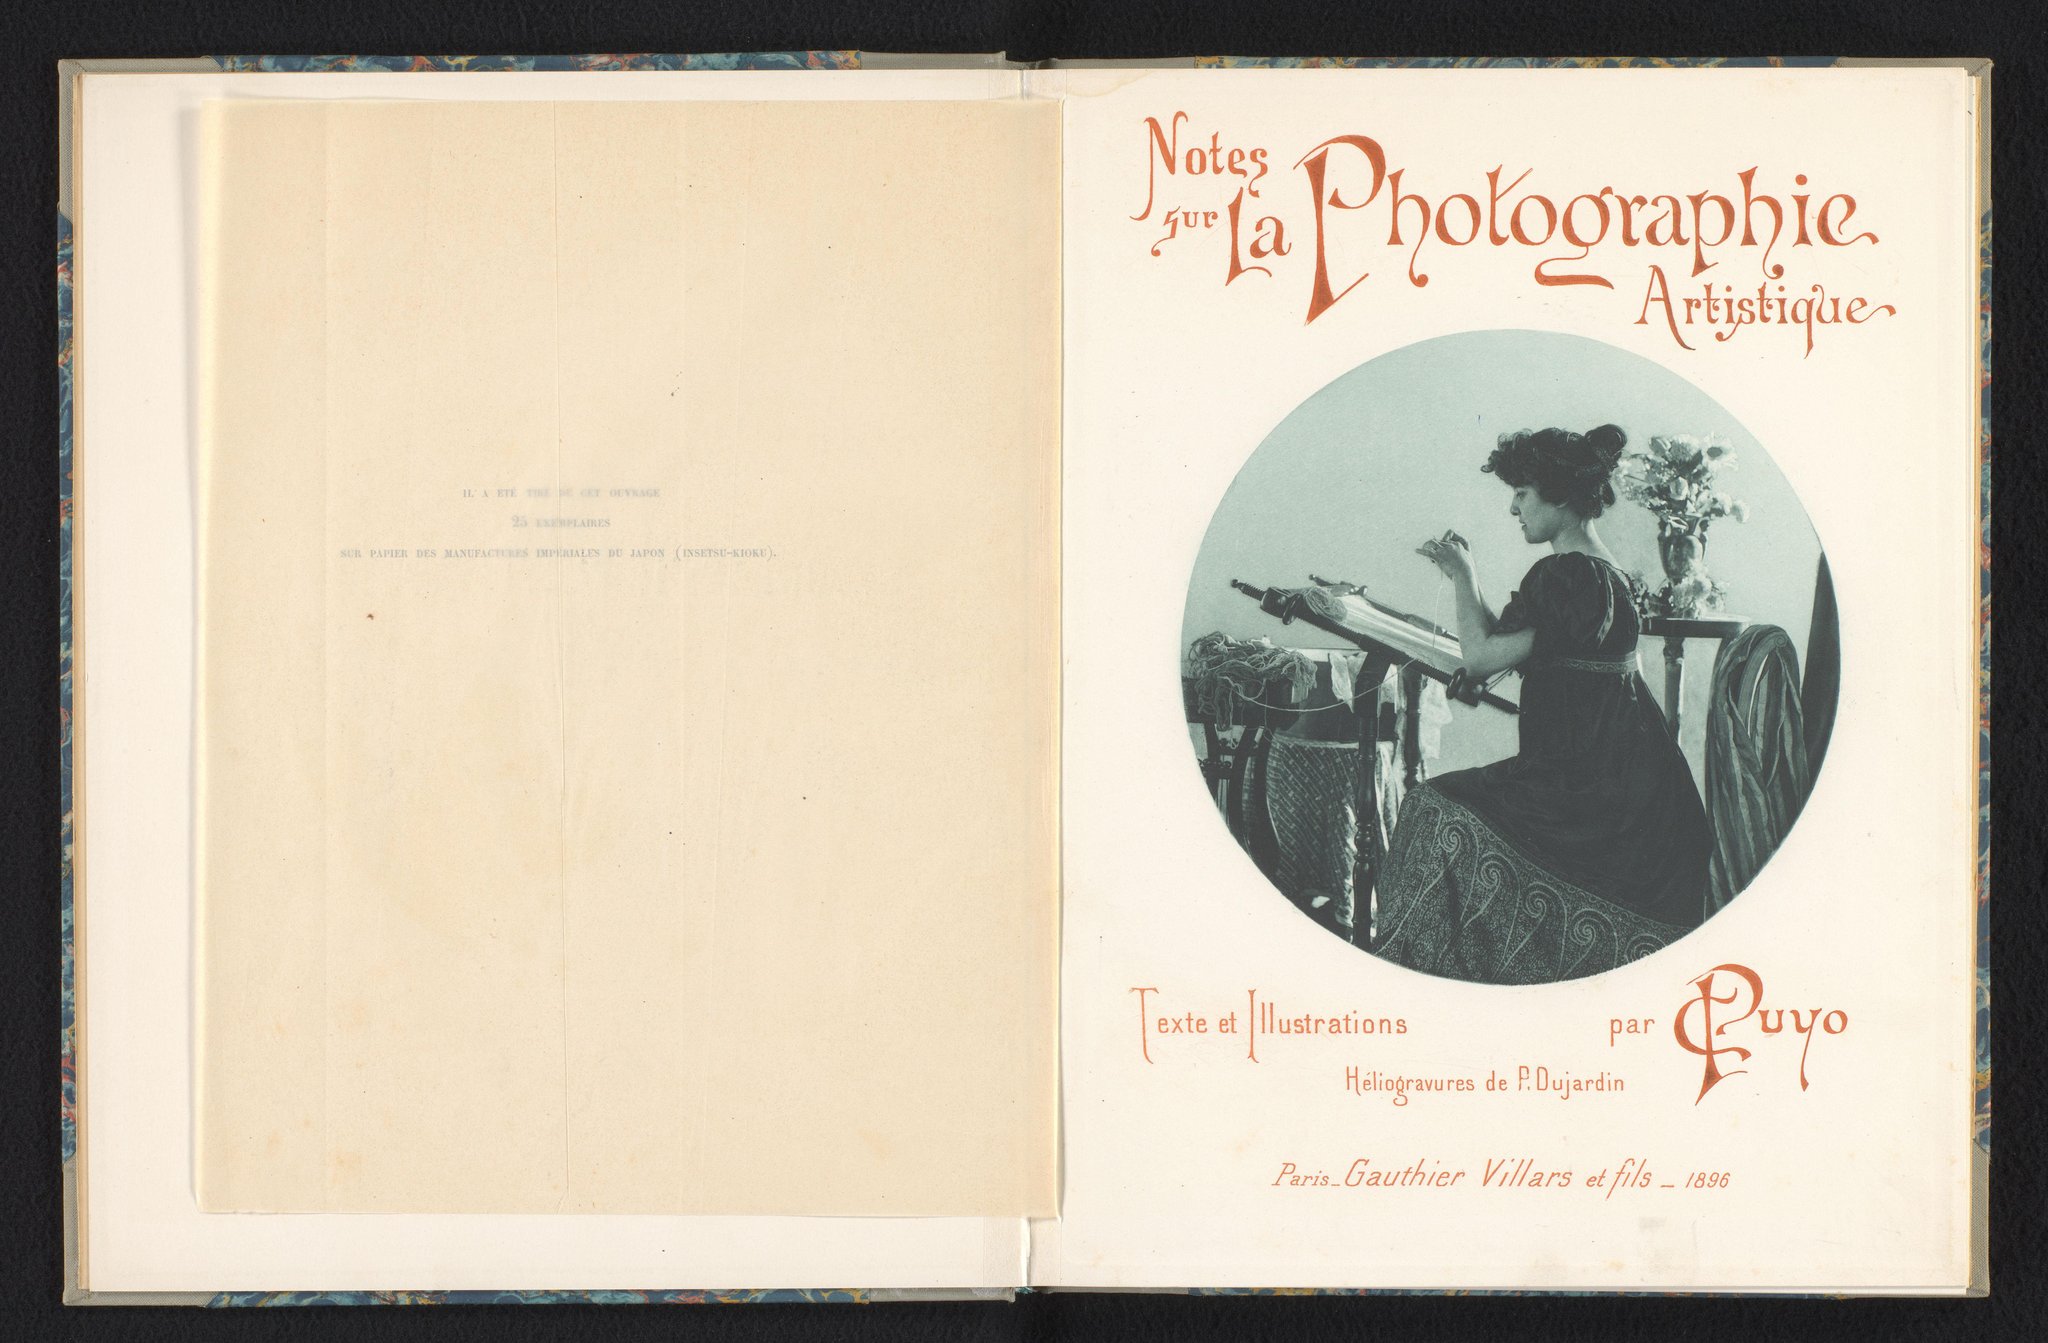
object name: page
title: Wevende vrouw in een interieur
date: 1891-1896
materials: paper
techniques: photoaquatint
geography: france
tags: adult woman, interior ~ representation of a building, weaving-loom, weaving